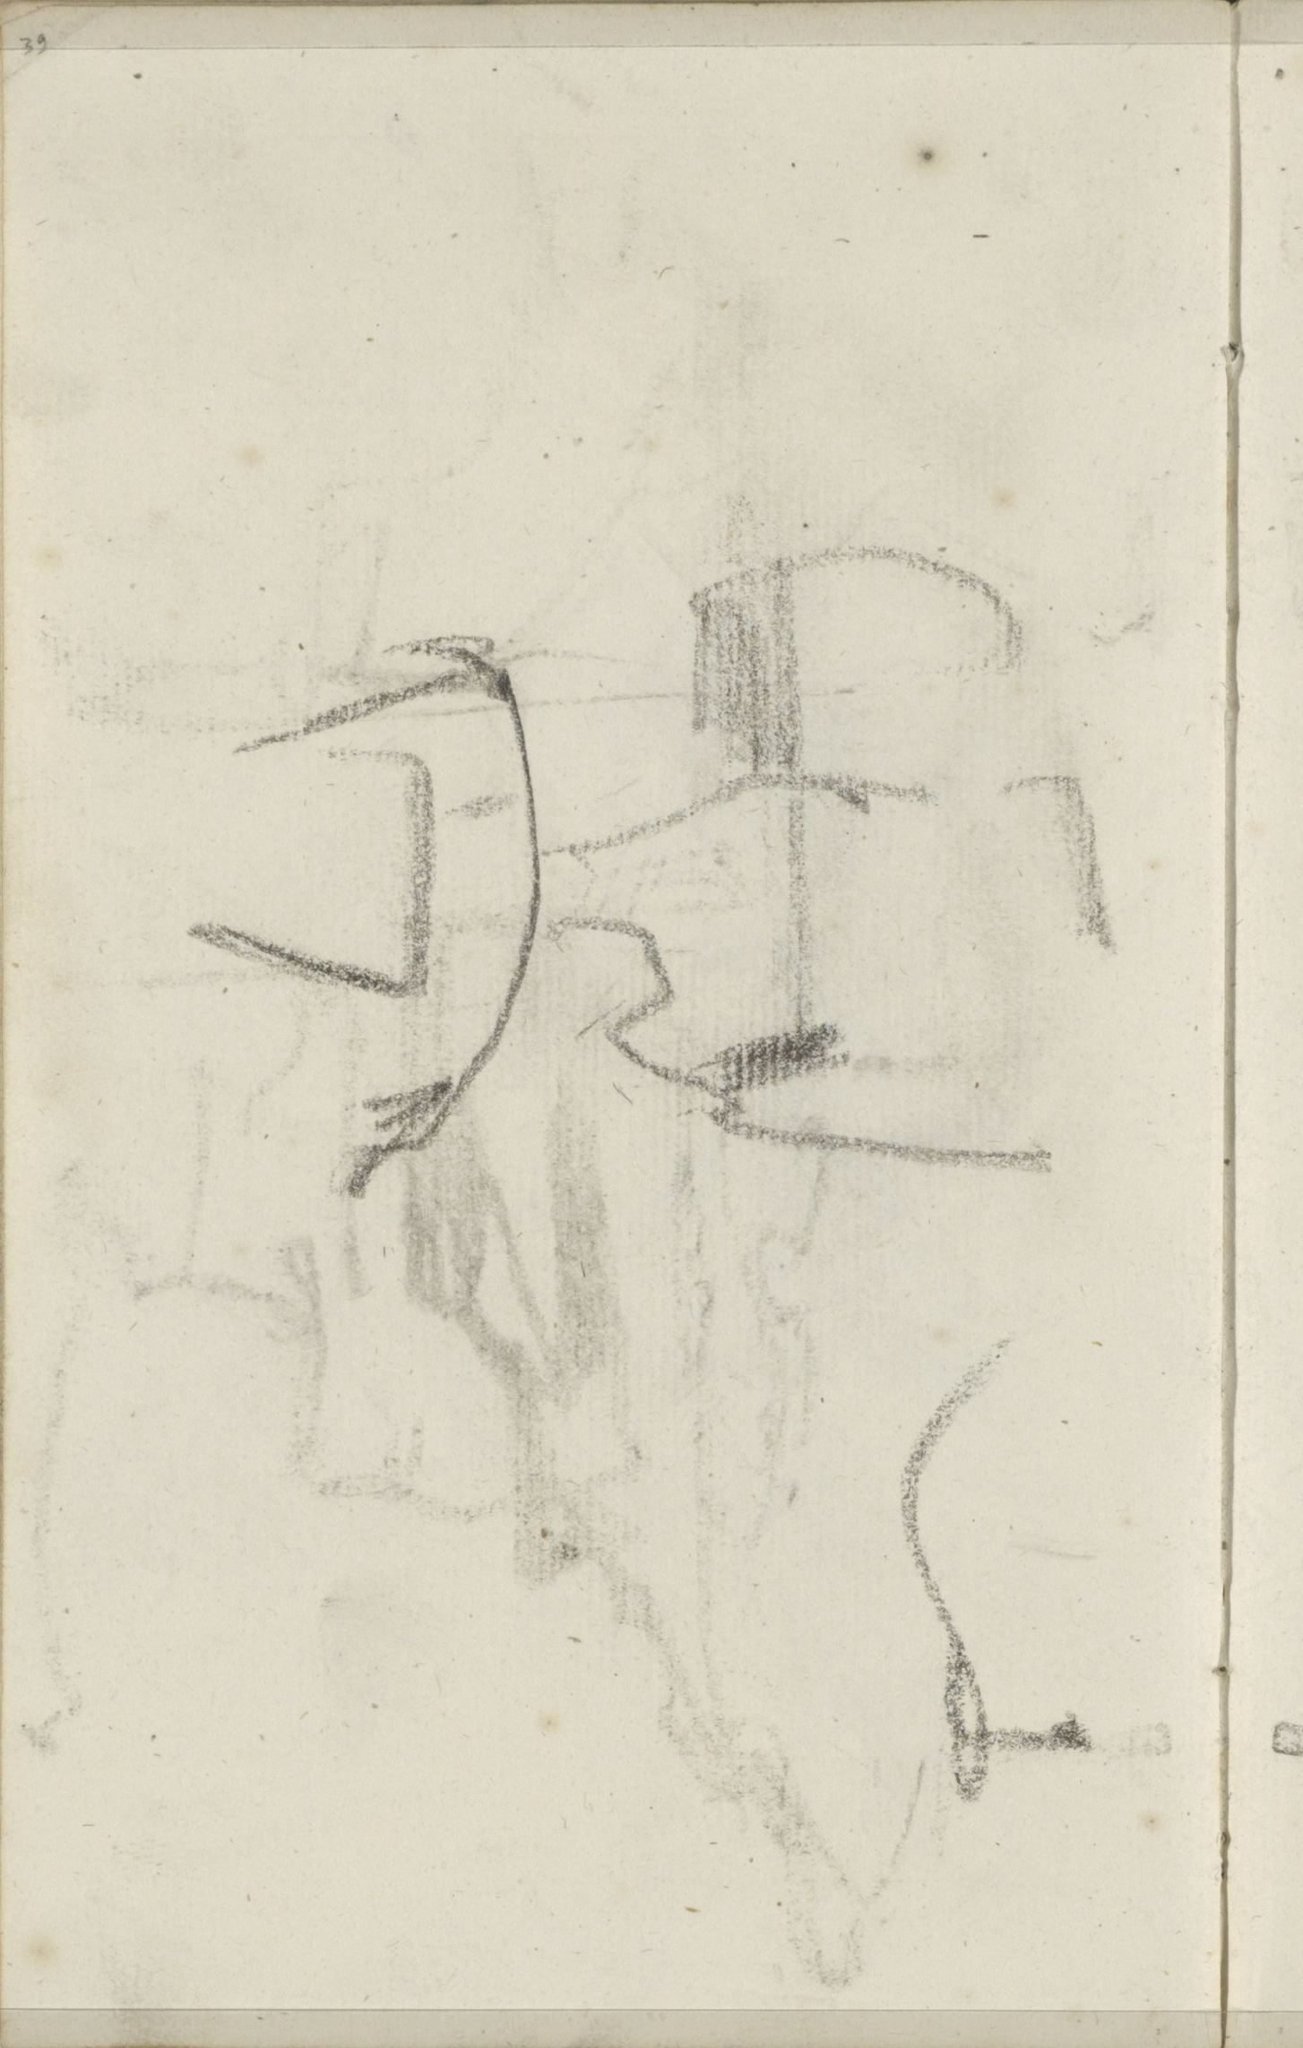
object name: sketchbook leaf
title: Studie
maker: george hendrik breitner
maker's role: draughtsman, painter, print maker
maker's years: 1857-1923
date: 1880-1882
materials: chalk, paper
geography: scheveningen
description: Pagina 39 uit een schetsboek met 31 bladen.